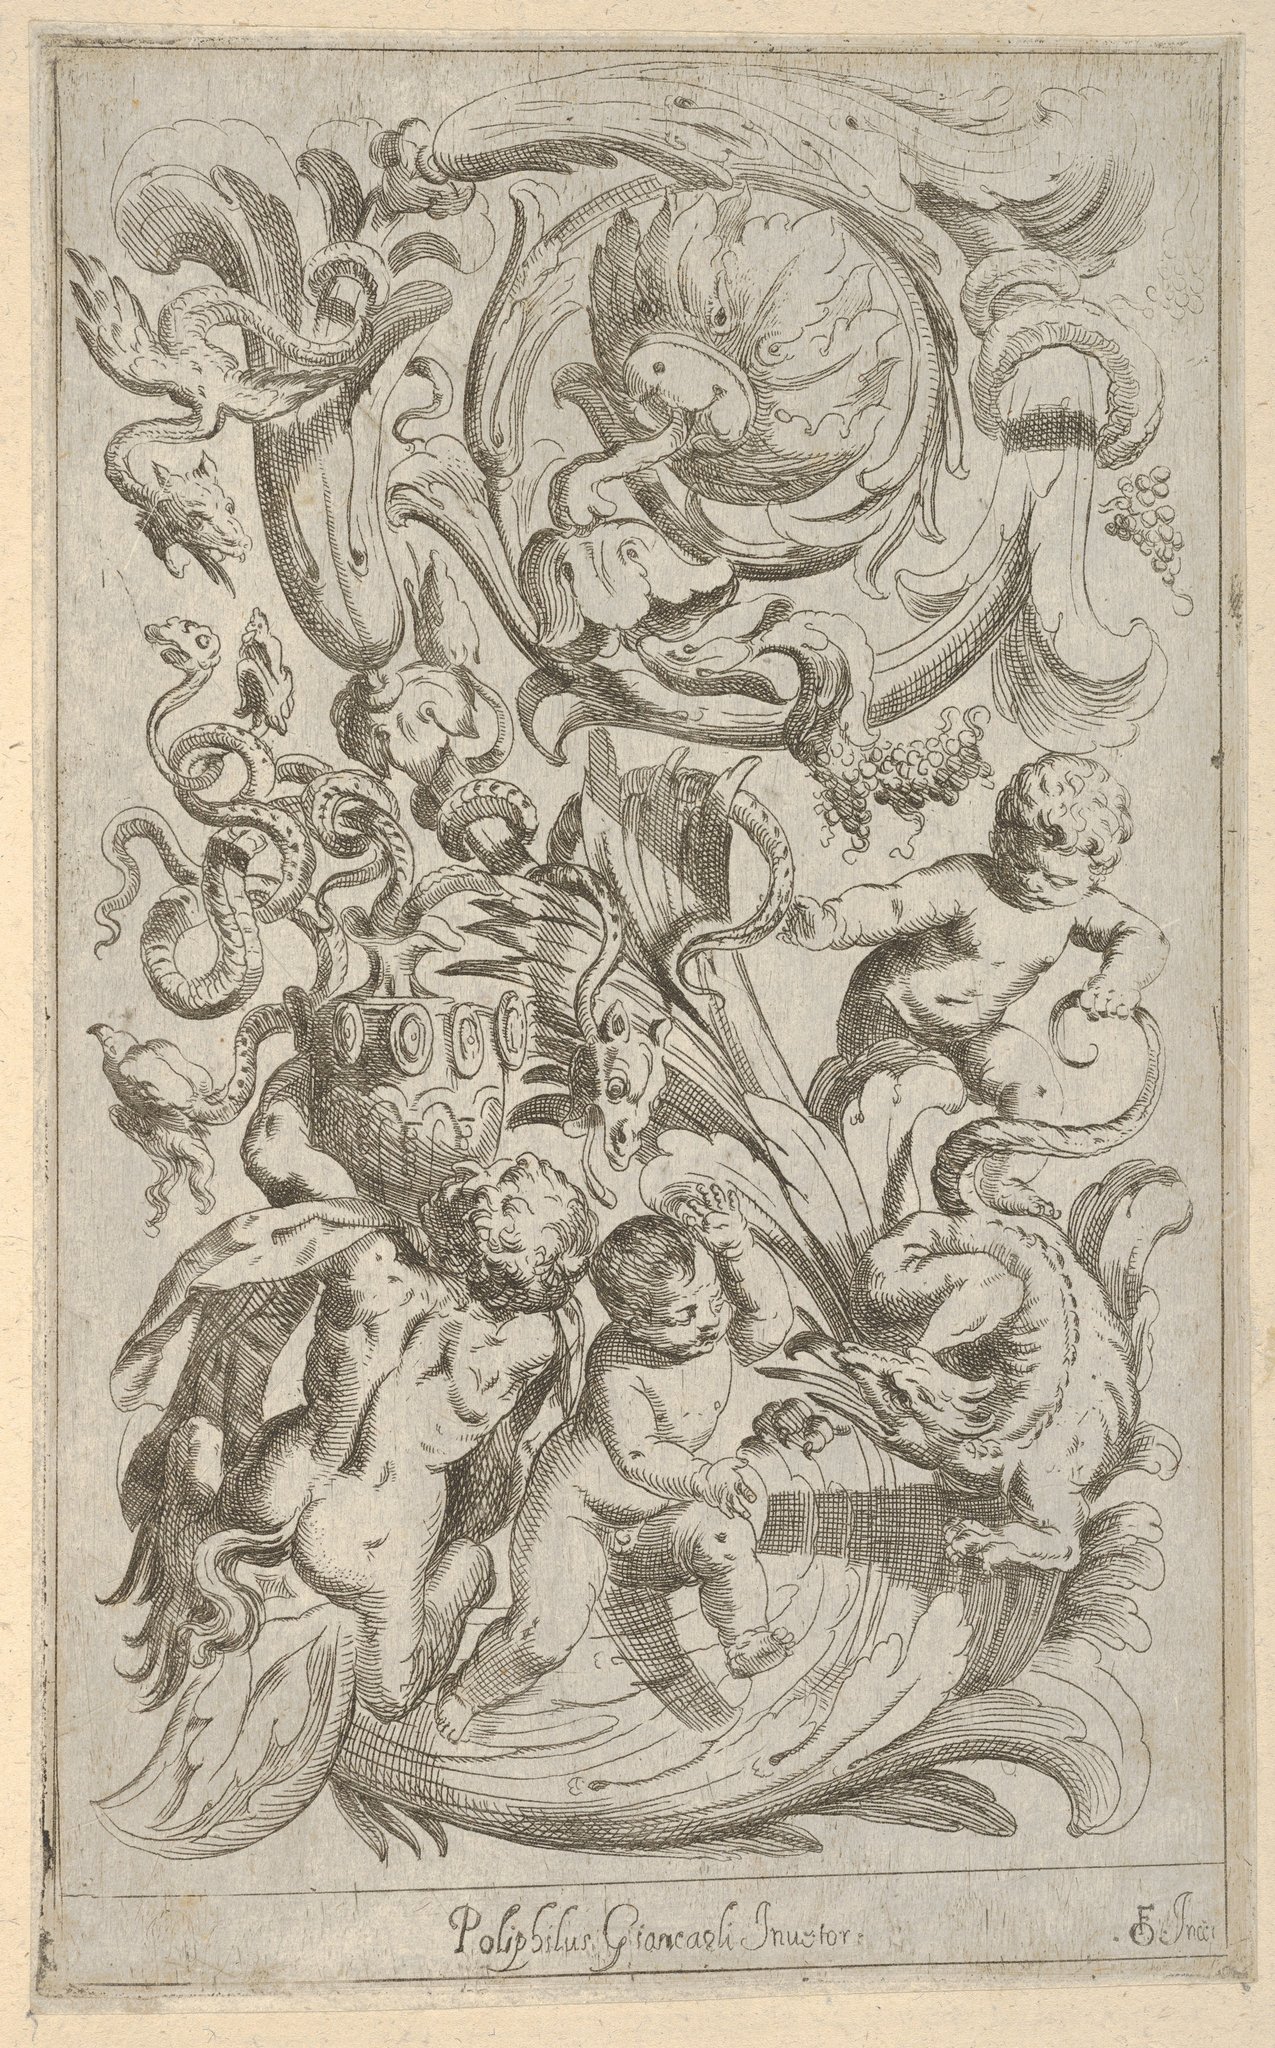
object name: collection ornament architecture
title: Disegni Varii di Polifilo Zancarli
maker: polifilo giancarli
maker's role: artist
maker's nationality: italian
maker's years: 1600-1625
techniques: etching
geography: italy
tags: dragons,satyrs,serpents,flowers